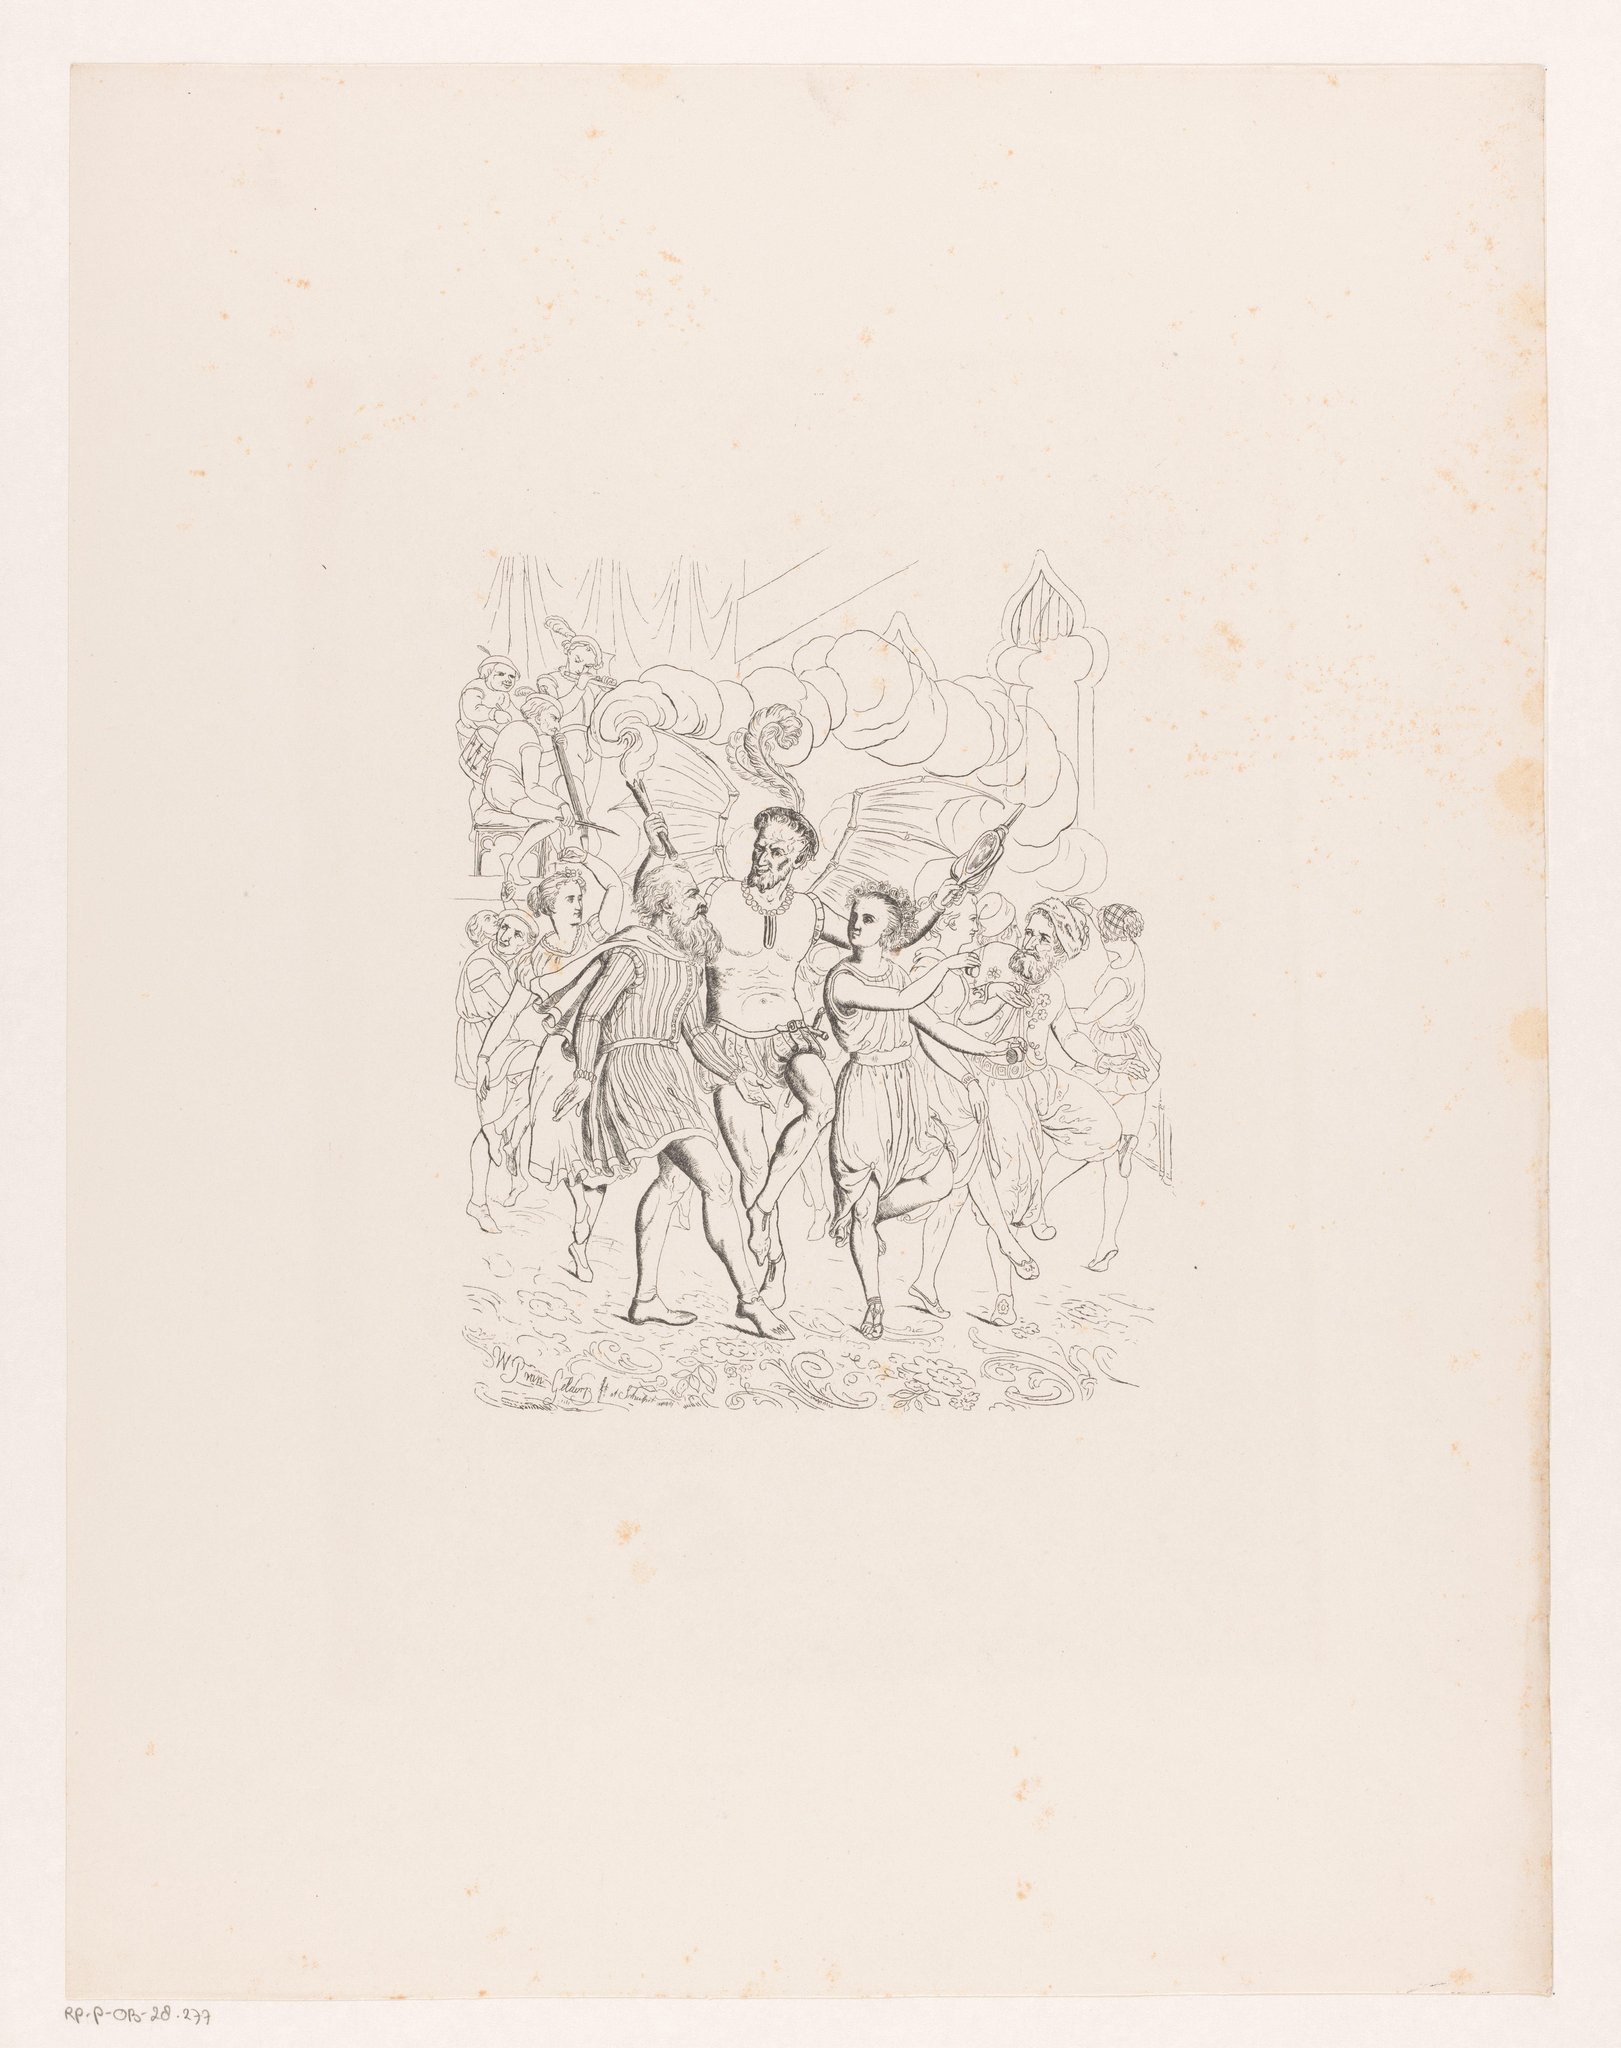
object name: print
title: Duivel en dansende figuren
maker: wilhelmus petrus van geldorp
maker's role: print maker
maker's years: 1832-1900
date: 1842-1900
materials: paper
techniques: lithograph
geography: rotterdam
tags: torch, devil(s) and demons, group dancing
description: De duivel danst tussen een oudere man en een meisje. Hij heeft een fakkel in zijn ene en een blaasbalg in de andere hand. In de achtergrond bespelen mannen muziekinstrumenten.